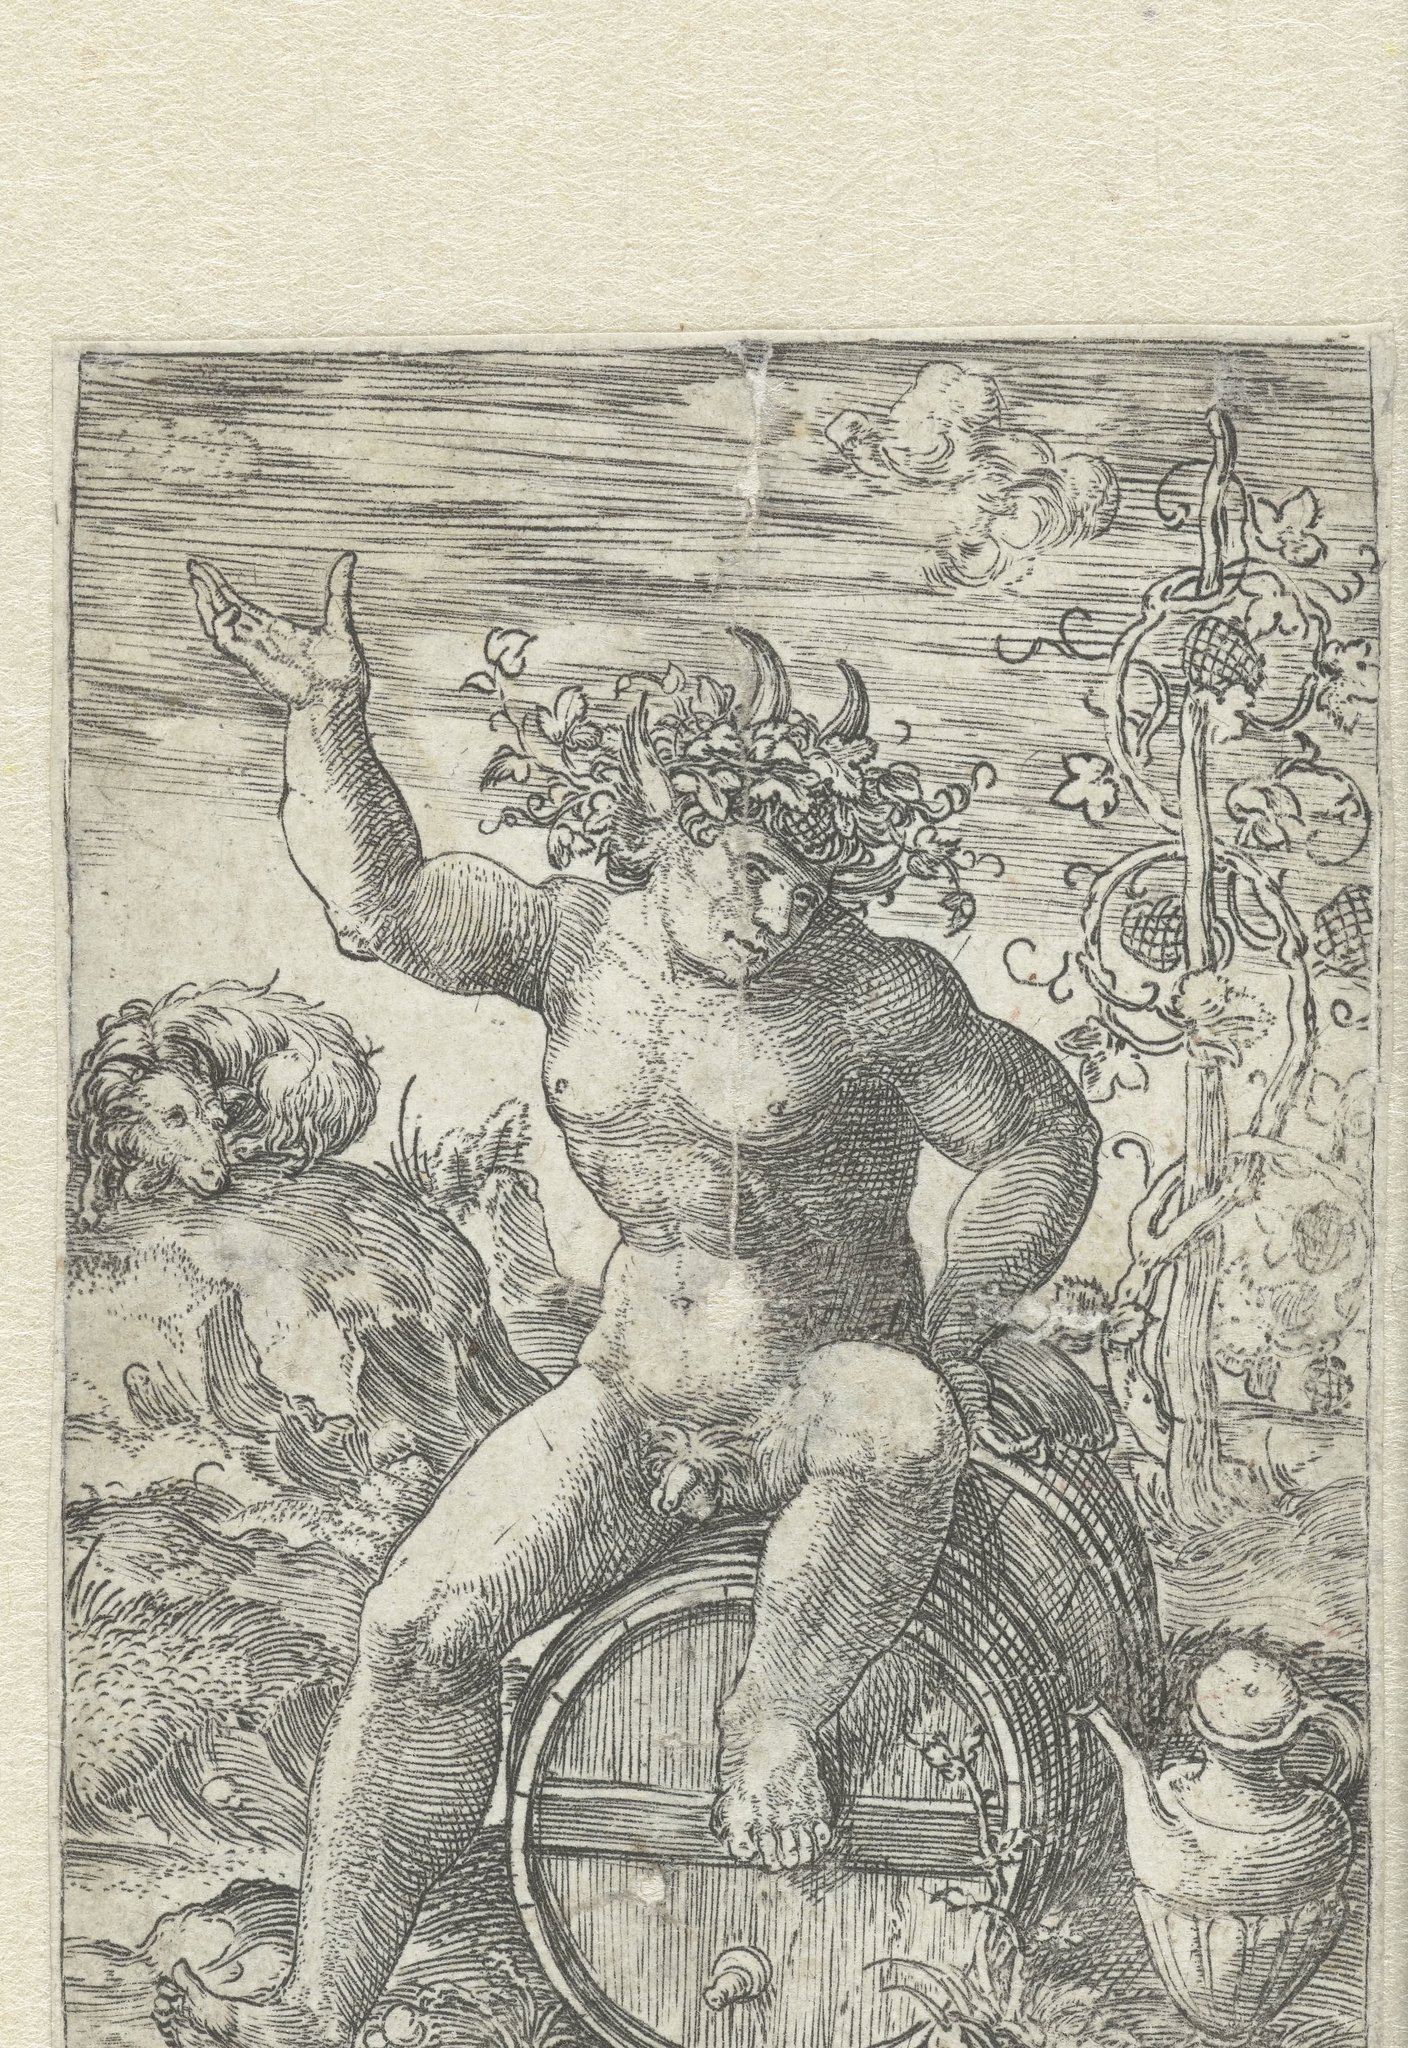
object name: print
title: Allegorie op de erfstadhouderschap aangeboden aan de prins van Oranje, 1674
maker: romeyn de hooghe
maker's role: draughtsman, goldsmith, painter, print maker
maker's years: 1645-1708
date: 1674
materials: paper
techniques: etching, letterpress printing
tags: johan van oldenbarnevelt, dordrecht, cornelis de witt, politician, johan de witt, the hague, william iii (prince of orange and king of england, scotland, and ireland), prudence, 'prudentia'; 'prudenza' (ripa) ~ one of the four cardinal virtues, courage, bravery, valiance, manliness; 'ardire magnanimo et generoso', 'gagliardezza', 'valore', 'virtù heroica', 'virtù dell'animo e del corpo' (ripa)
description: Allegorie op de afschaffing van het Eeuwig Edict uit 1667 met het aanbieden van het erfstadhouderschap aan de prins van Oranje, 2 februari 1674. Vervallen monument waarin Anticurius van Loevestein (de personificatie van de Loevesteinse factie) op zijn doodsbed ligt, omgeven door allegorische figuren, waaronder de Acte van Seclusie. Bovenaan een borstbeeld van Van Oldenbarnevelt bij een opschrift en aan weerszijden de lichamen van de gebroeders De Witt. Rechts een medaillon met het portret van Willem III, vastgehouden door Dapperheid en Voorzichtigheid. Bij de voorstelling een los tekstblad met tekst in 3 kolommen met een verklaring van de cijfers 1-18 in het Nederlands.